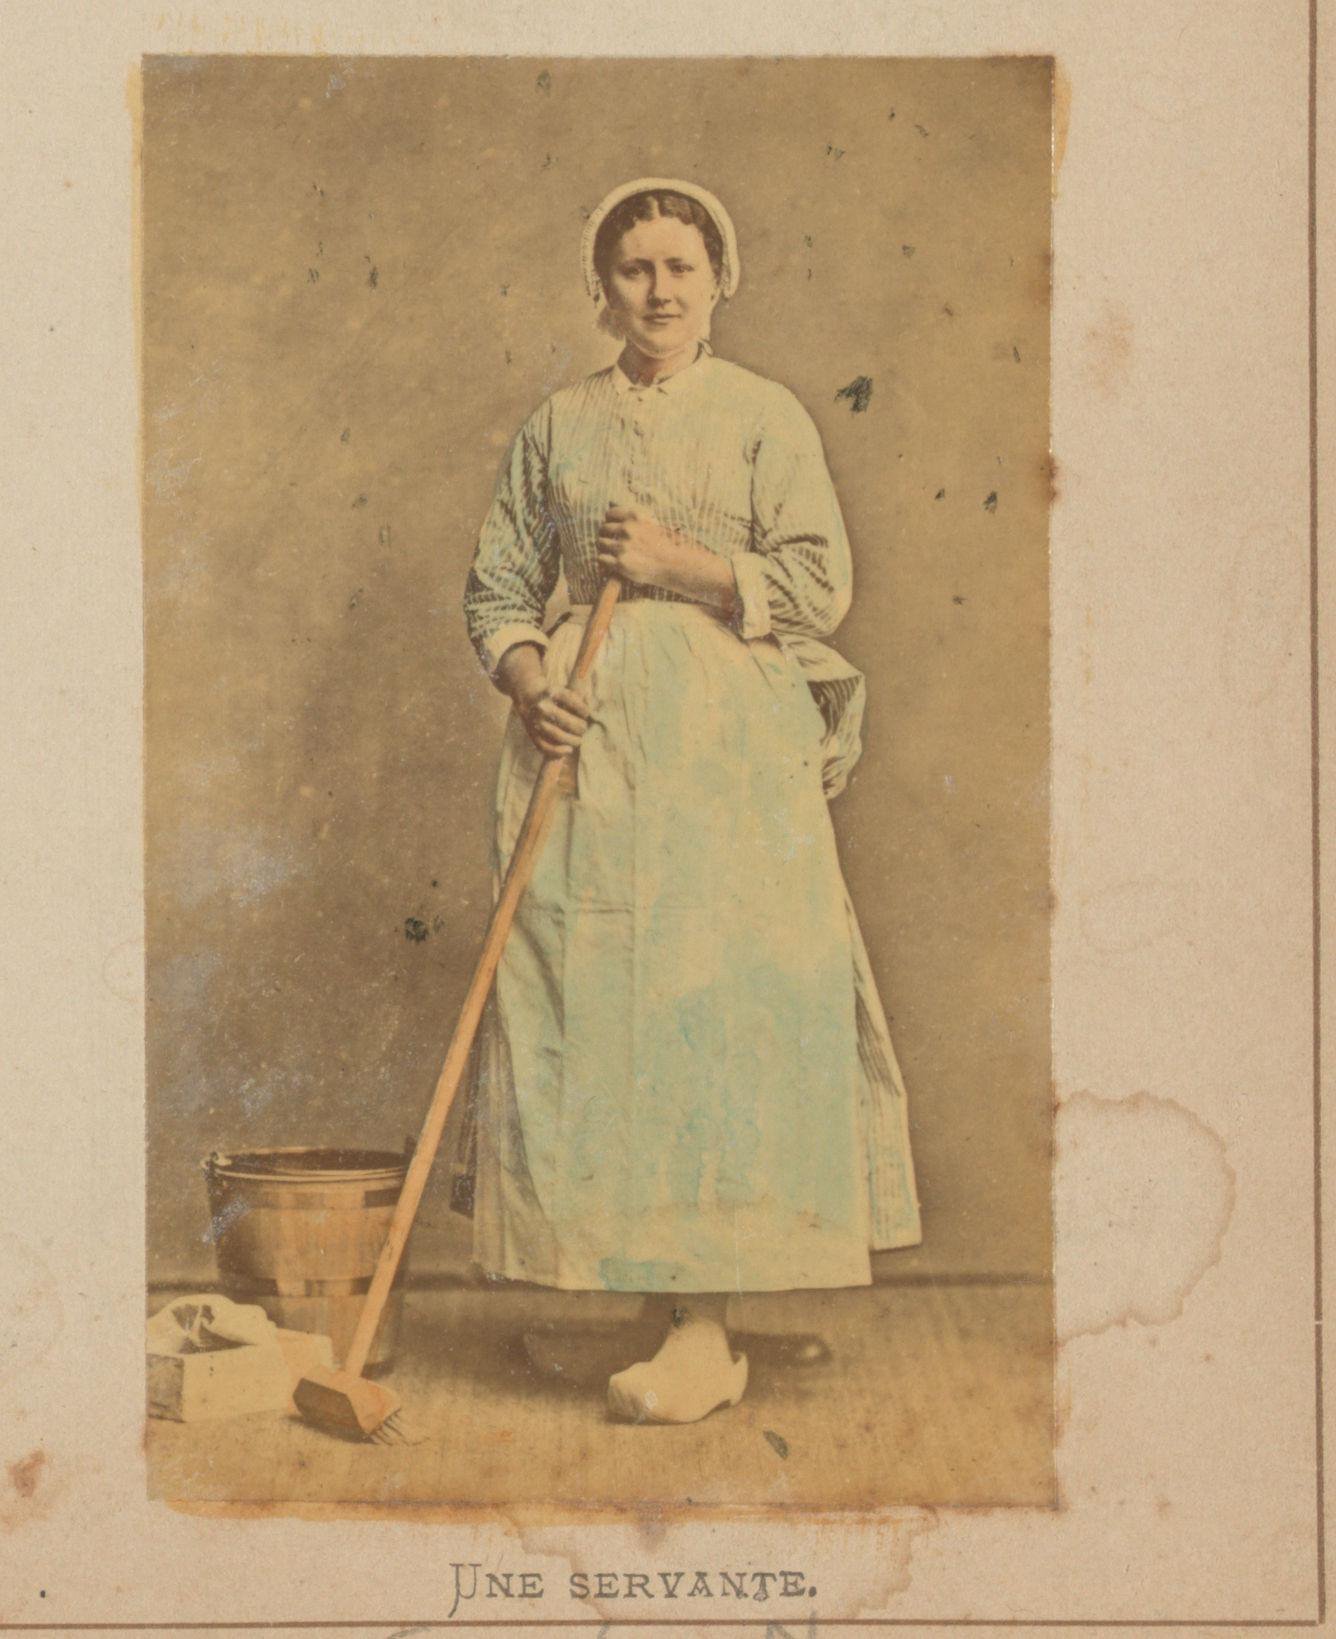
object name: photograph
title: Portret van dienstmeisje in werkkleding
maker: andries jager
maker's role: publisher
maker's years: 1825-1905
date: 1875-1910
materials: cardboard, paper, photographic support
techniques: albumen print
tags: wooden container: barrel, cask, bucket, clothing for the upper part of the body: blouse (+ women's clothes), wooden shoes, clogs, head-gear: cap, apron (+ women's clothes), shrubs: broom, house personnel, servants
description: Onderdeel van Leporelloalbum met 28 foto's van Amsterdam en omstreken.